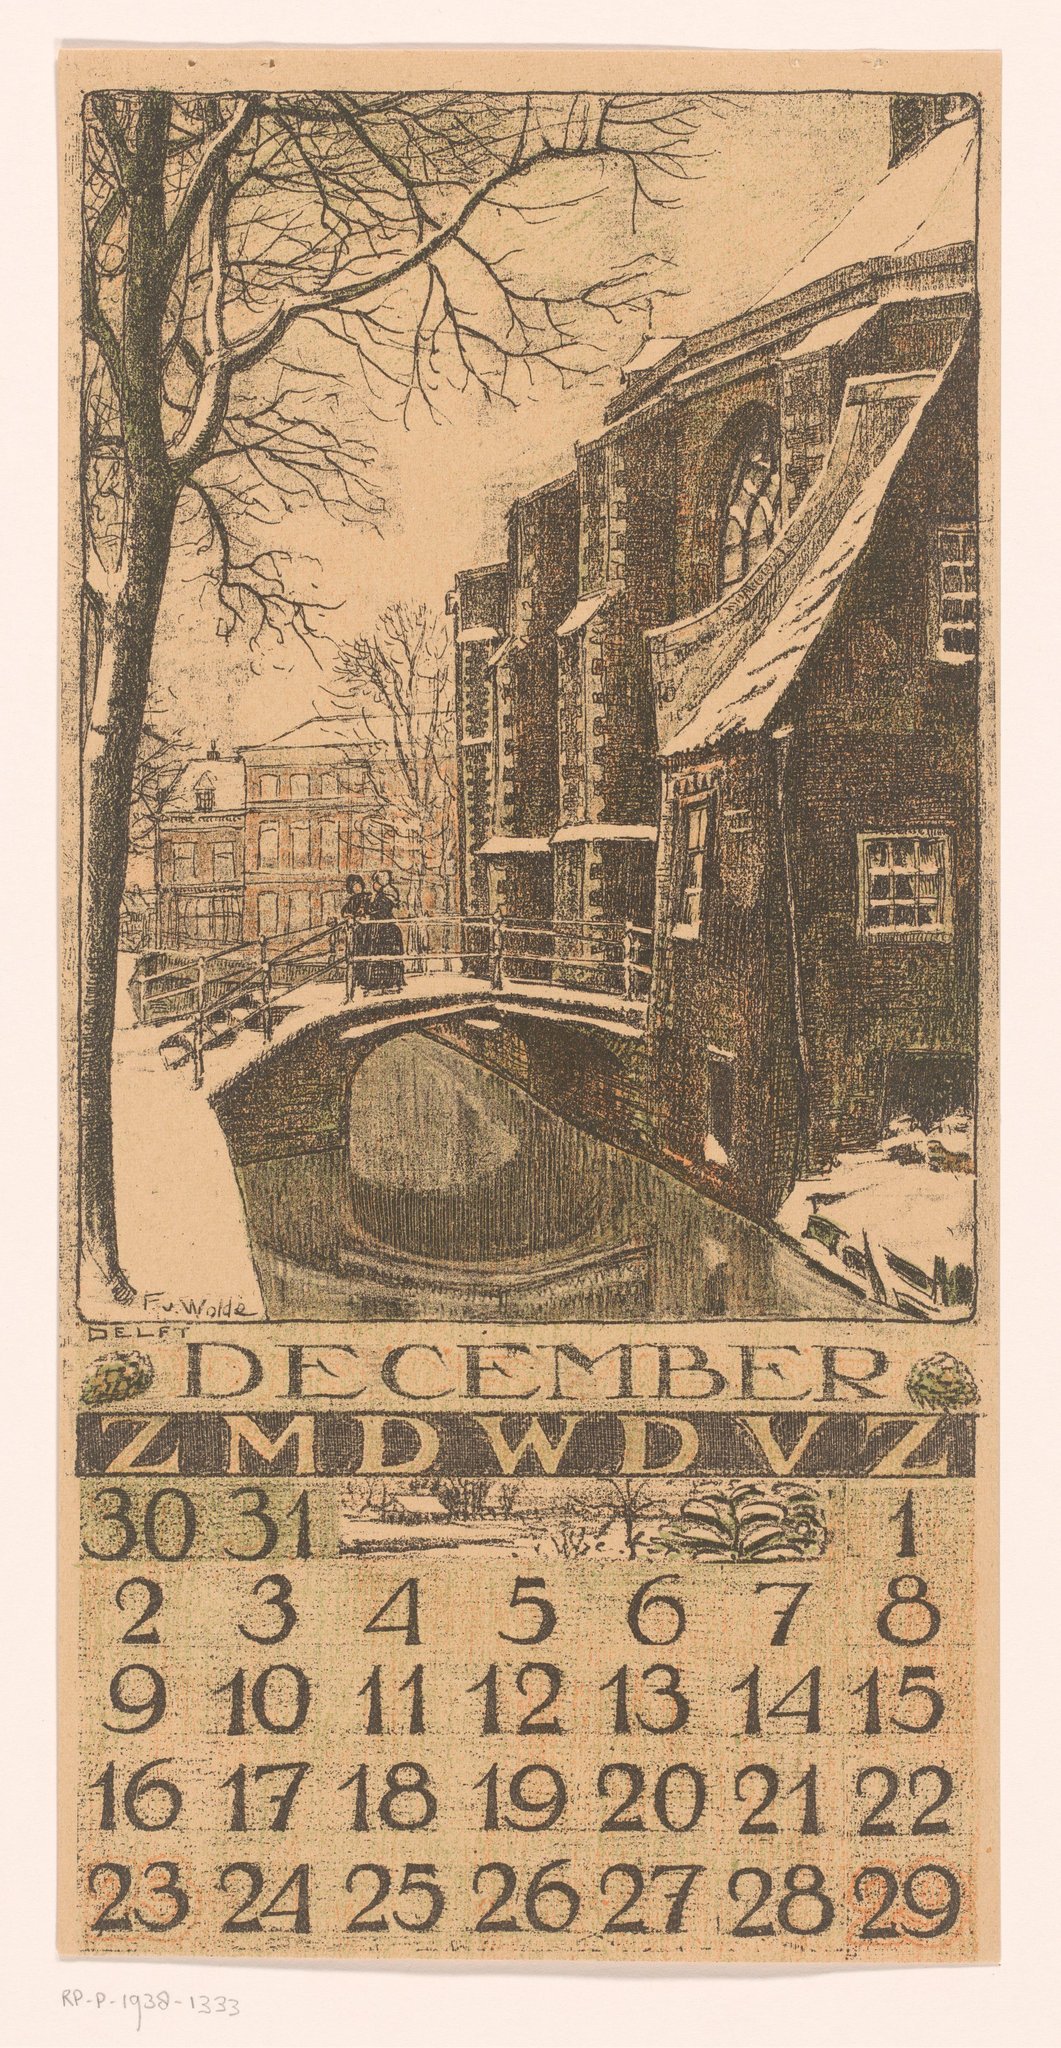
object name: print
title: Kalenderblad december met stadsgezicht in Delft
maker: ferdinand van wolde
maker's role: print maker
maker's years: 1891-1945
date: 1923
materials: paper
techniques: lithograph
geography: netherlands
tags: bridge in city across river, canal, etc. (+ city(-scape) with figures, staffage), december ~ other concepts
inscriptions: collector's mark: Lugt 2228, collector's mark: Lugt 2760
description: Twee vrouwen staan op een brug naast de Nieuwe Kerk.